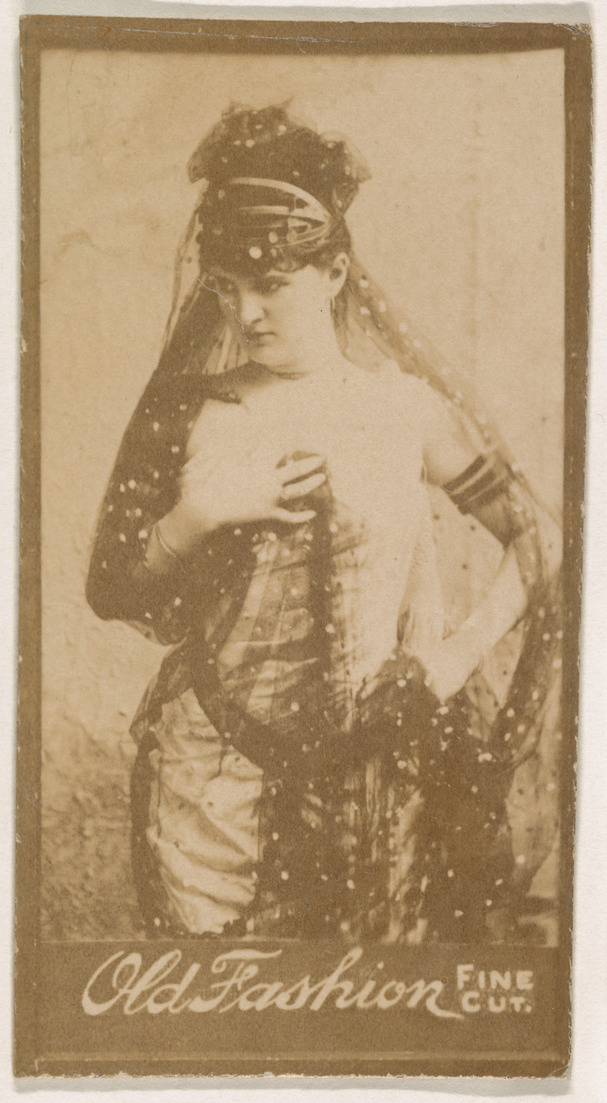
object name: photograph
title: Actress wearing costume with lace head scarf, from the Actresses series (N664) promoting Old Fashion Fine Cut Tobacco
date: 1888-1890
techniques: albumen silver print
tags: portraits,women,actresses